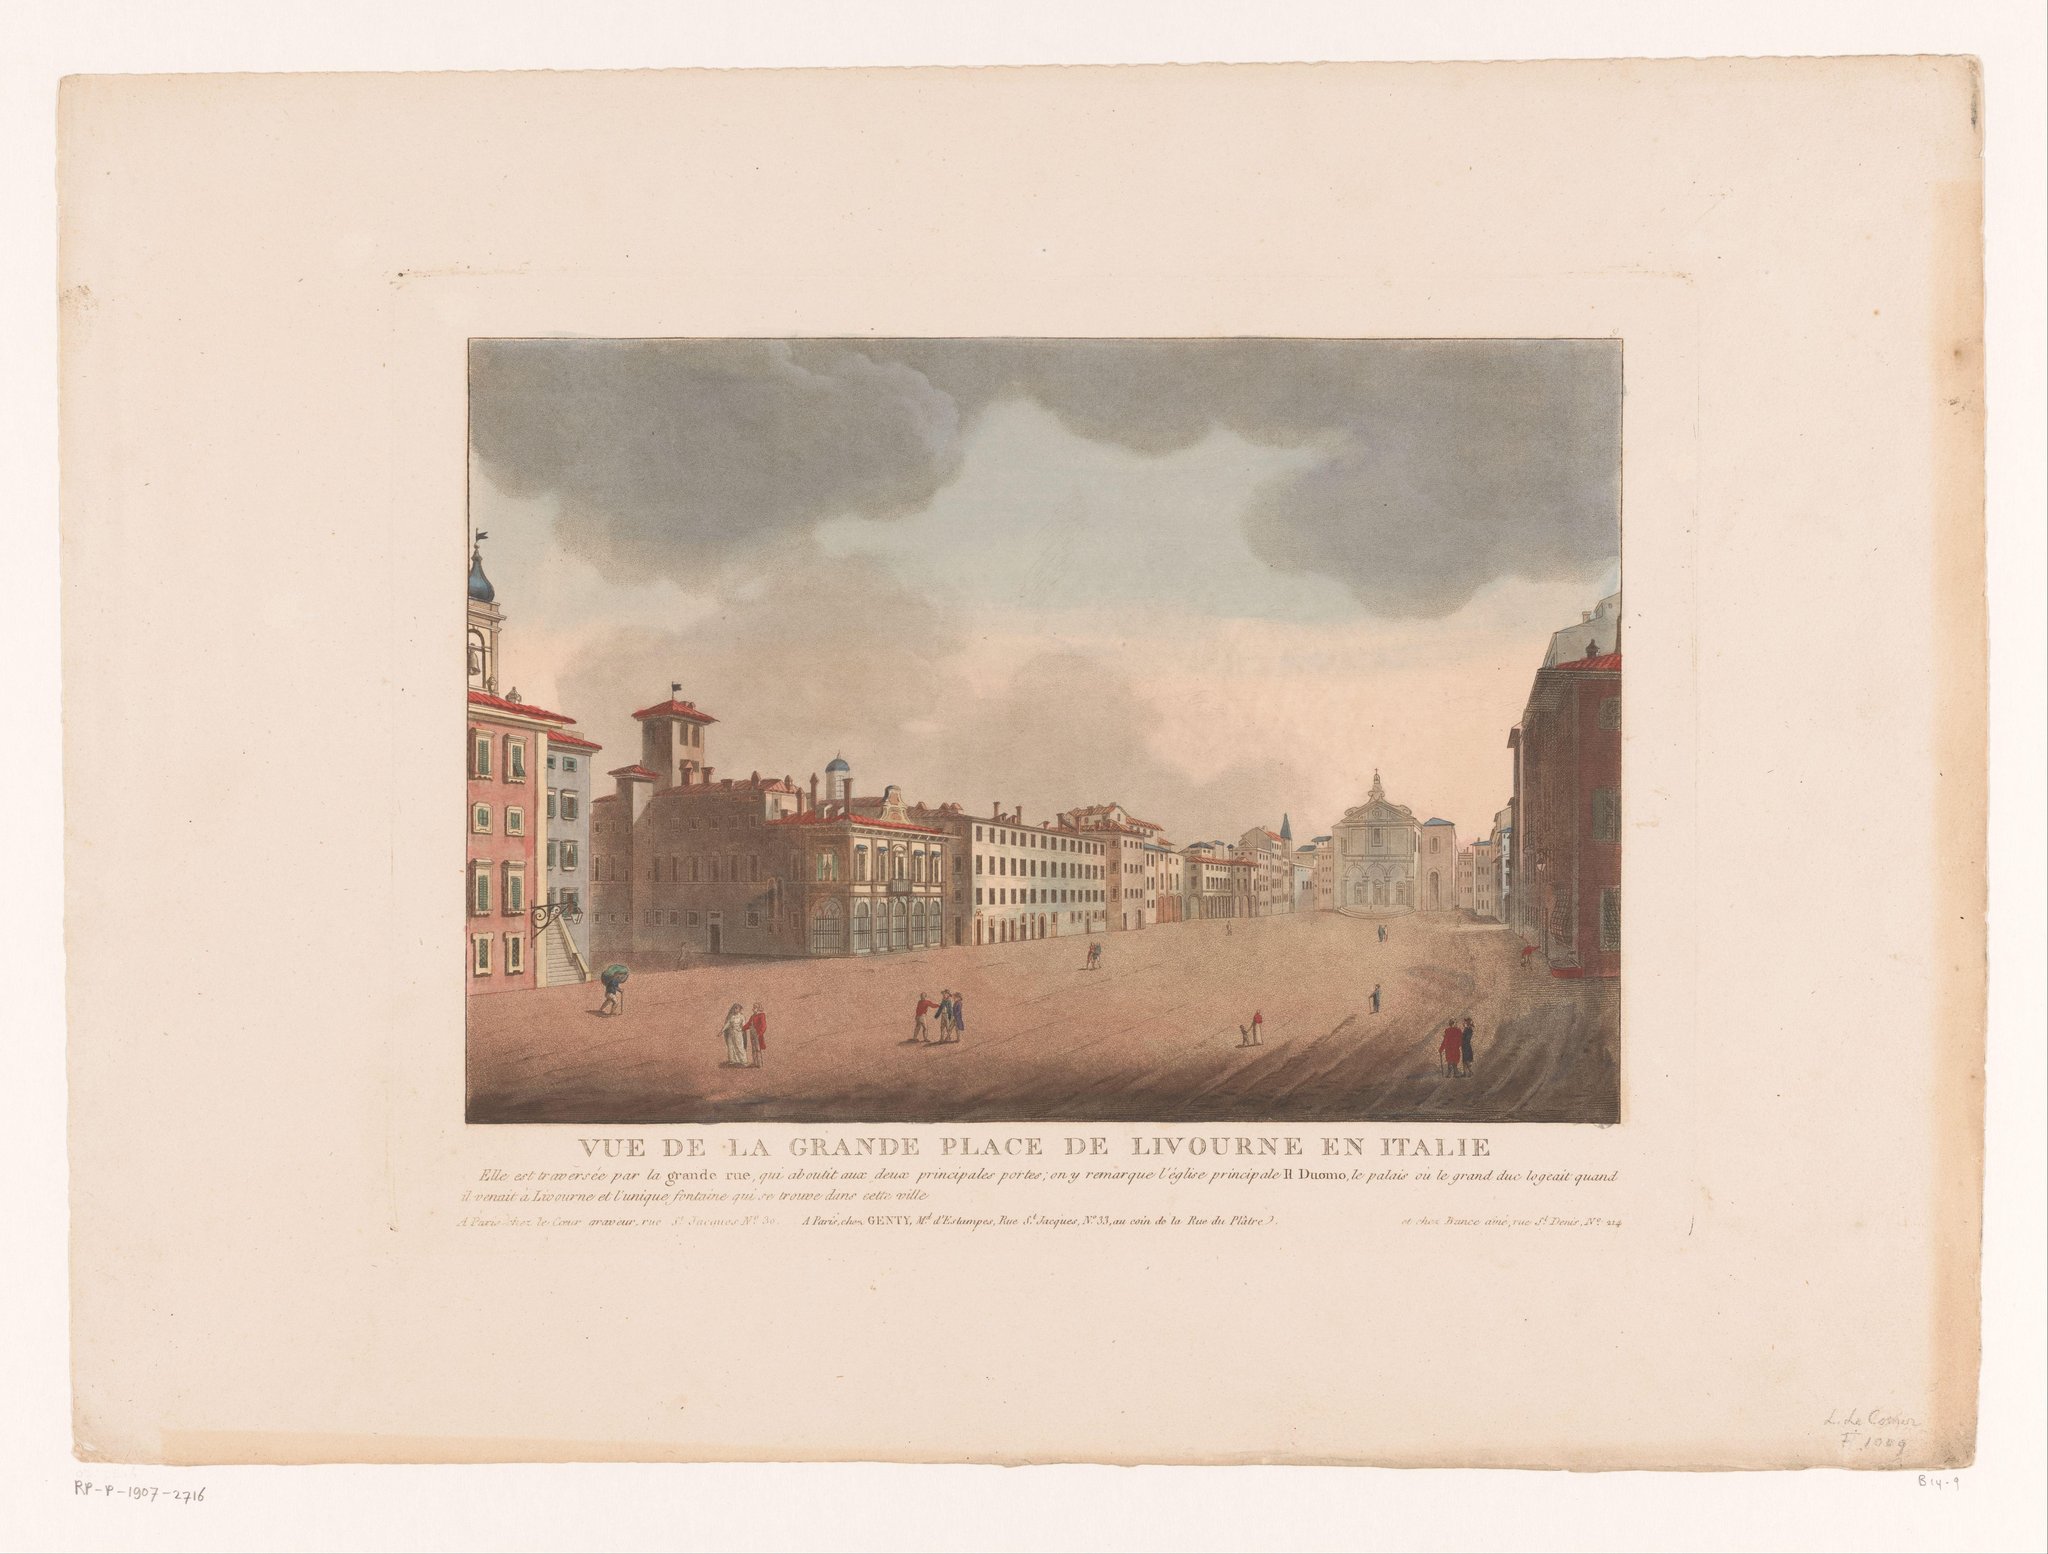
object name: print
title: Gezicht op het Piazza Grande te Livorno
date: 1812-1814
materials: paper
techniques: aquatint, etching, hand coloring, roulette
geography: paris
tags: square, place, circus, etc., church (exterior)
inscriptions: collector's mark: Lugt 2228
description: Maakt mogelijk deel uit van een serie met stadsgezichten in Italië, Spanje en Egypte.